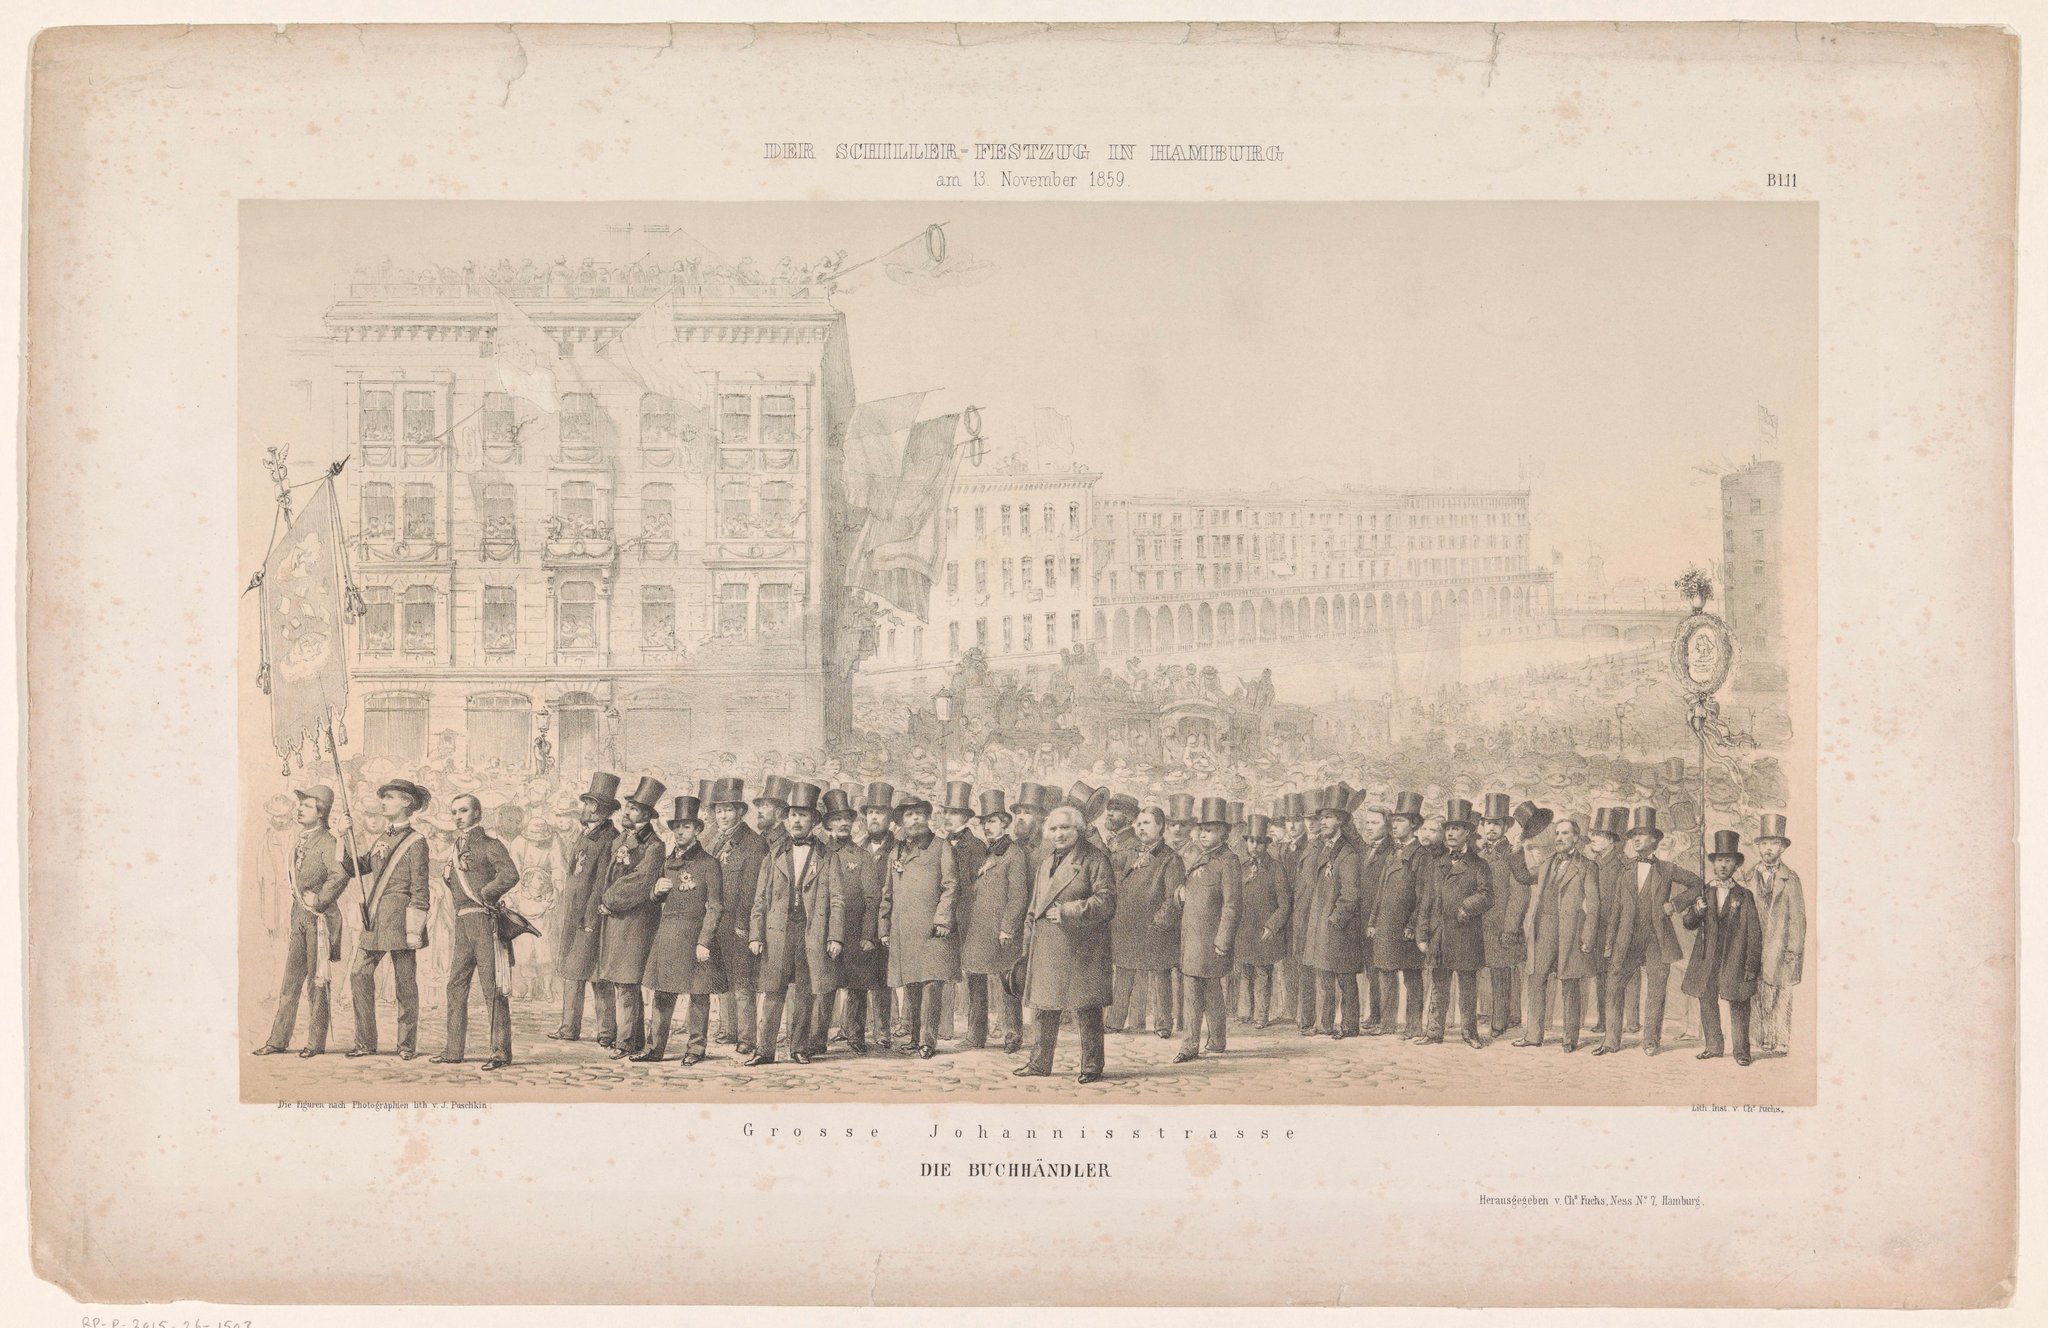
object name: print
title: Der Schiller-Festzug in Hamburg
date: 1811-1859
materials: paper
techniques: tone lithography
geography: hamburg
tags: public festivities, banner, standard (as symbol of the state, etc.), book-shop, bookseller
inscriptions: collector's mark: Lugt 4779, collector's mark: Lugt 4780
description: Gezicht op de Grosse Johannisstrasse in Hamburg met een optocht van boekhandelaren. Voorop loopt een man met een vaandel, bestaande uit een hand die vanuit de lucht boeken over de aarde strooit. Rechtsboven genummerd: Bl. 11.